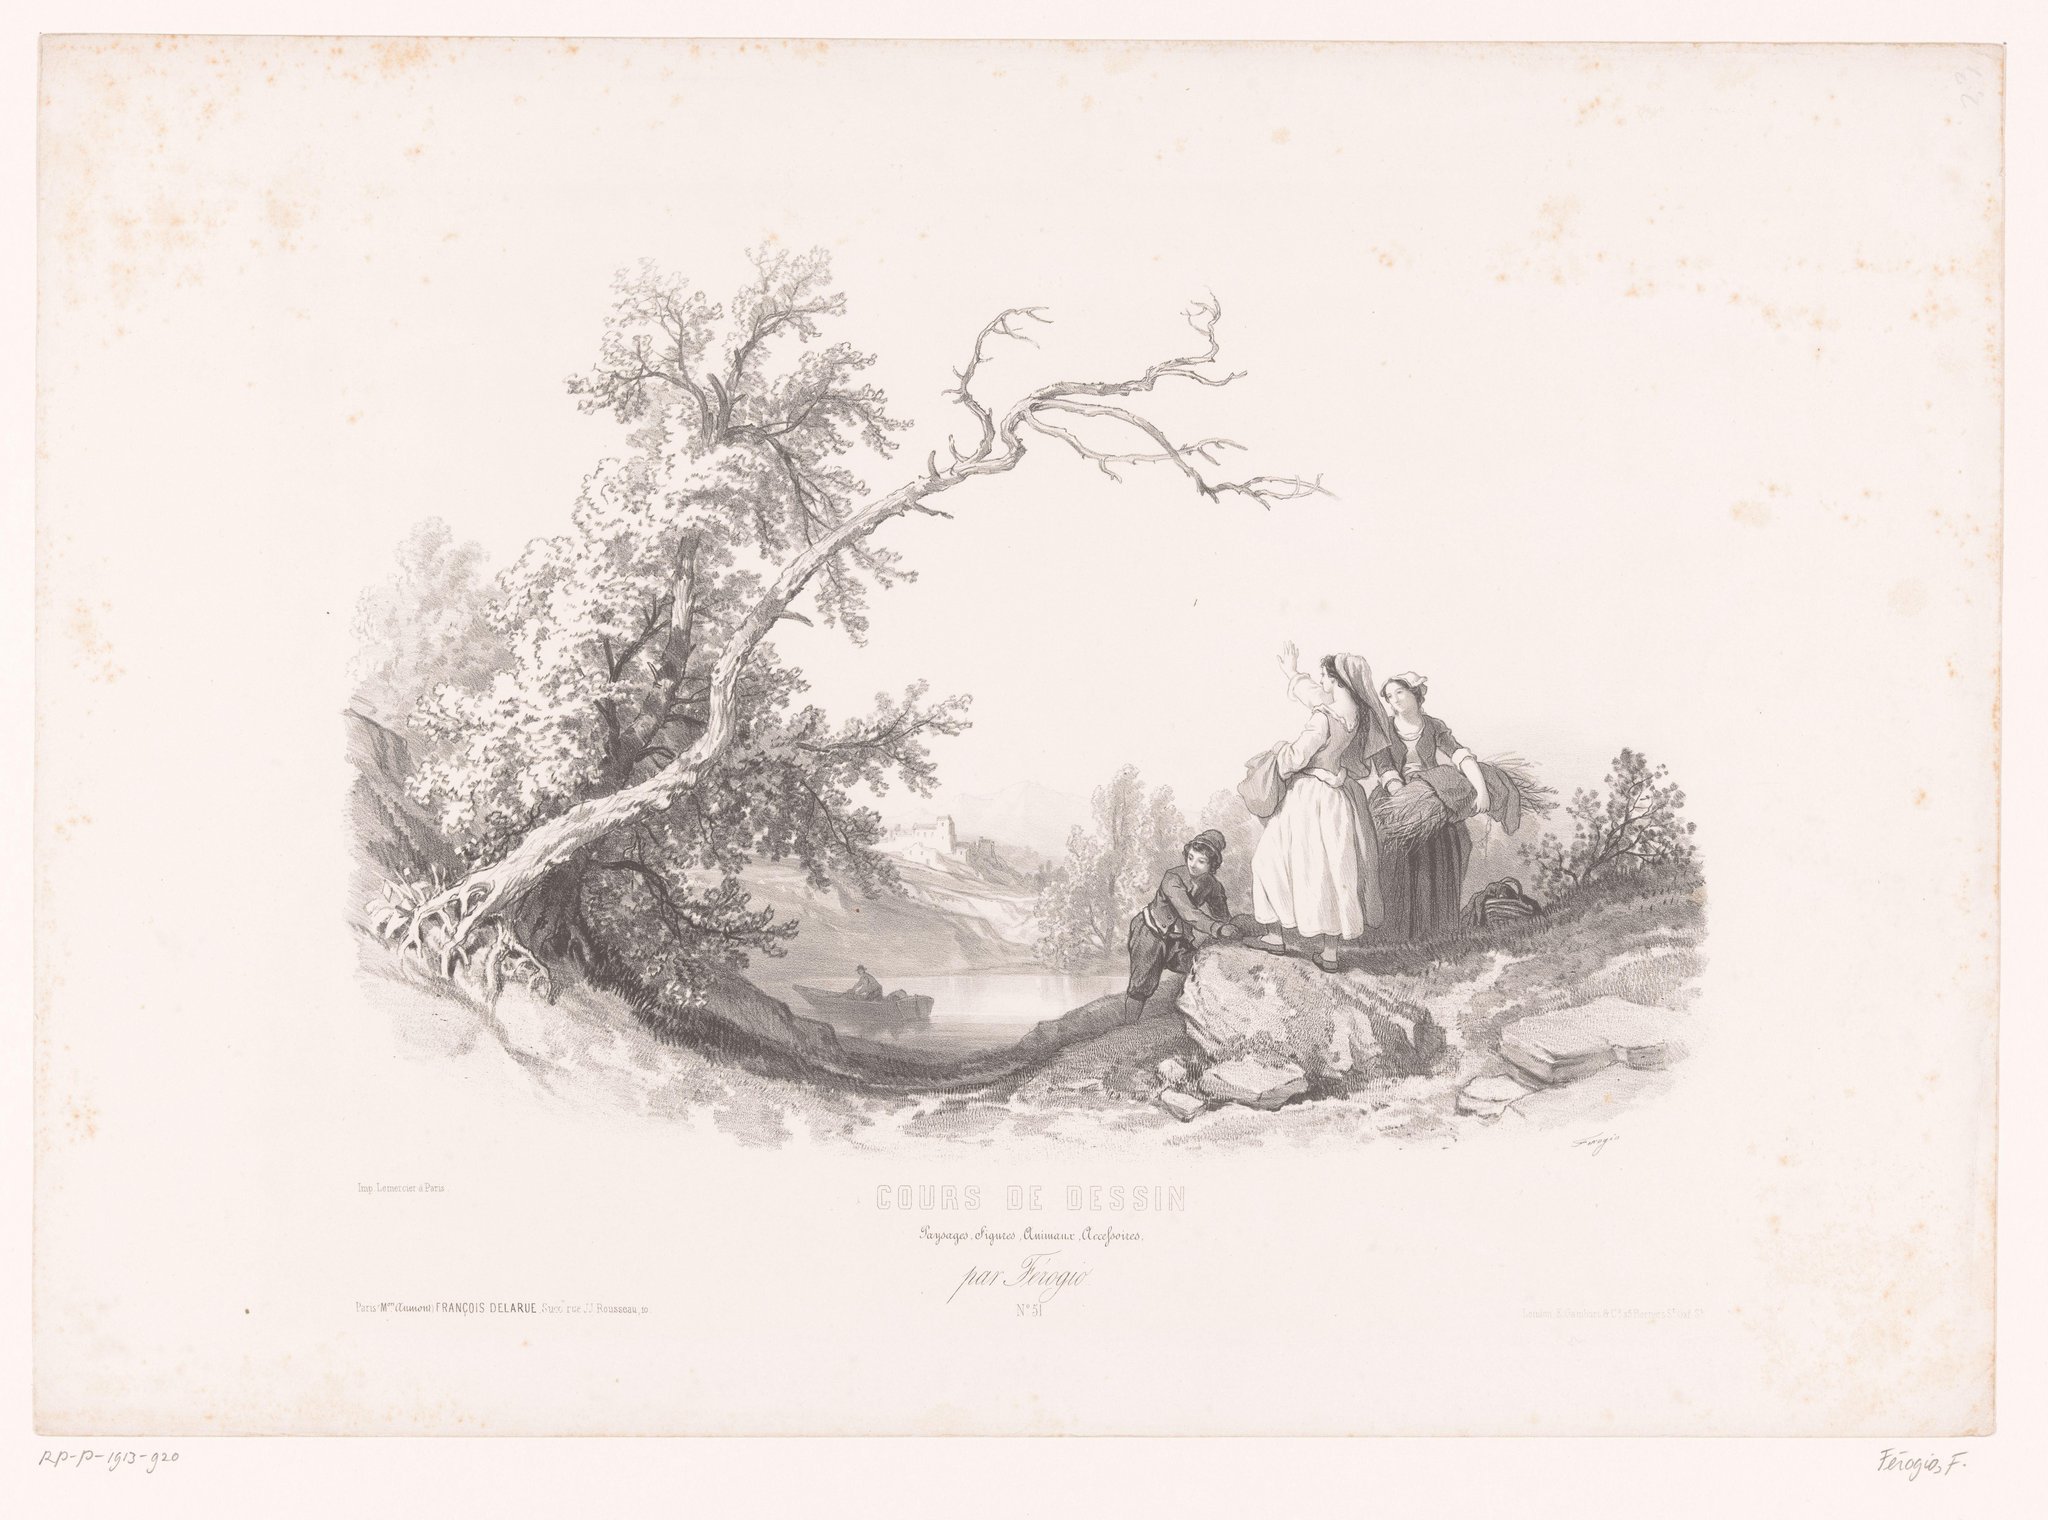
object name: print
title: Vrouw groet een man in een boot op het meer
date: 1845-1846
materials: paper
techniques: lithograph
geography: paris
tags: country dwellers, rowing-boat, canoe, etc., taking leave, lake (+ landscape with figures, staffage)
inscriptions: collector's mark: Lugt 2228a